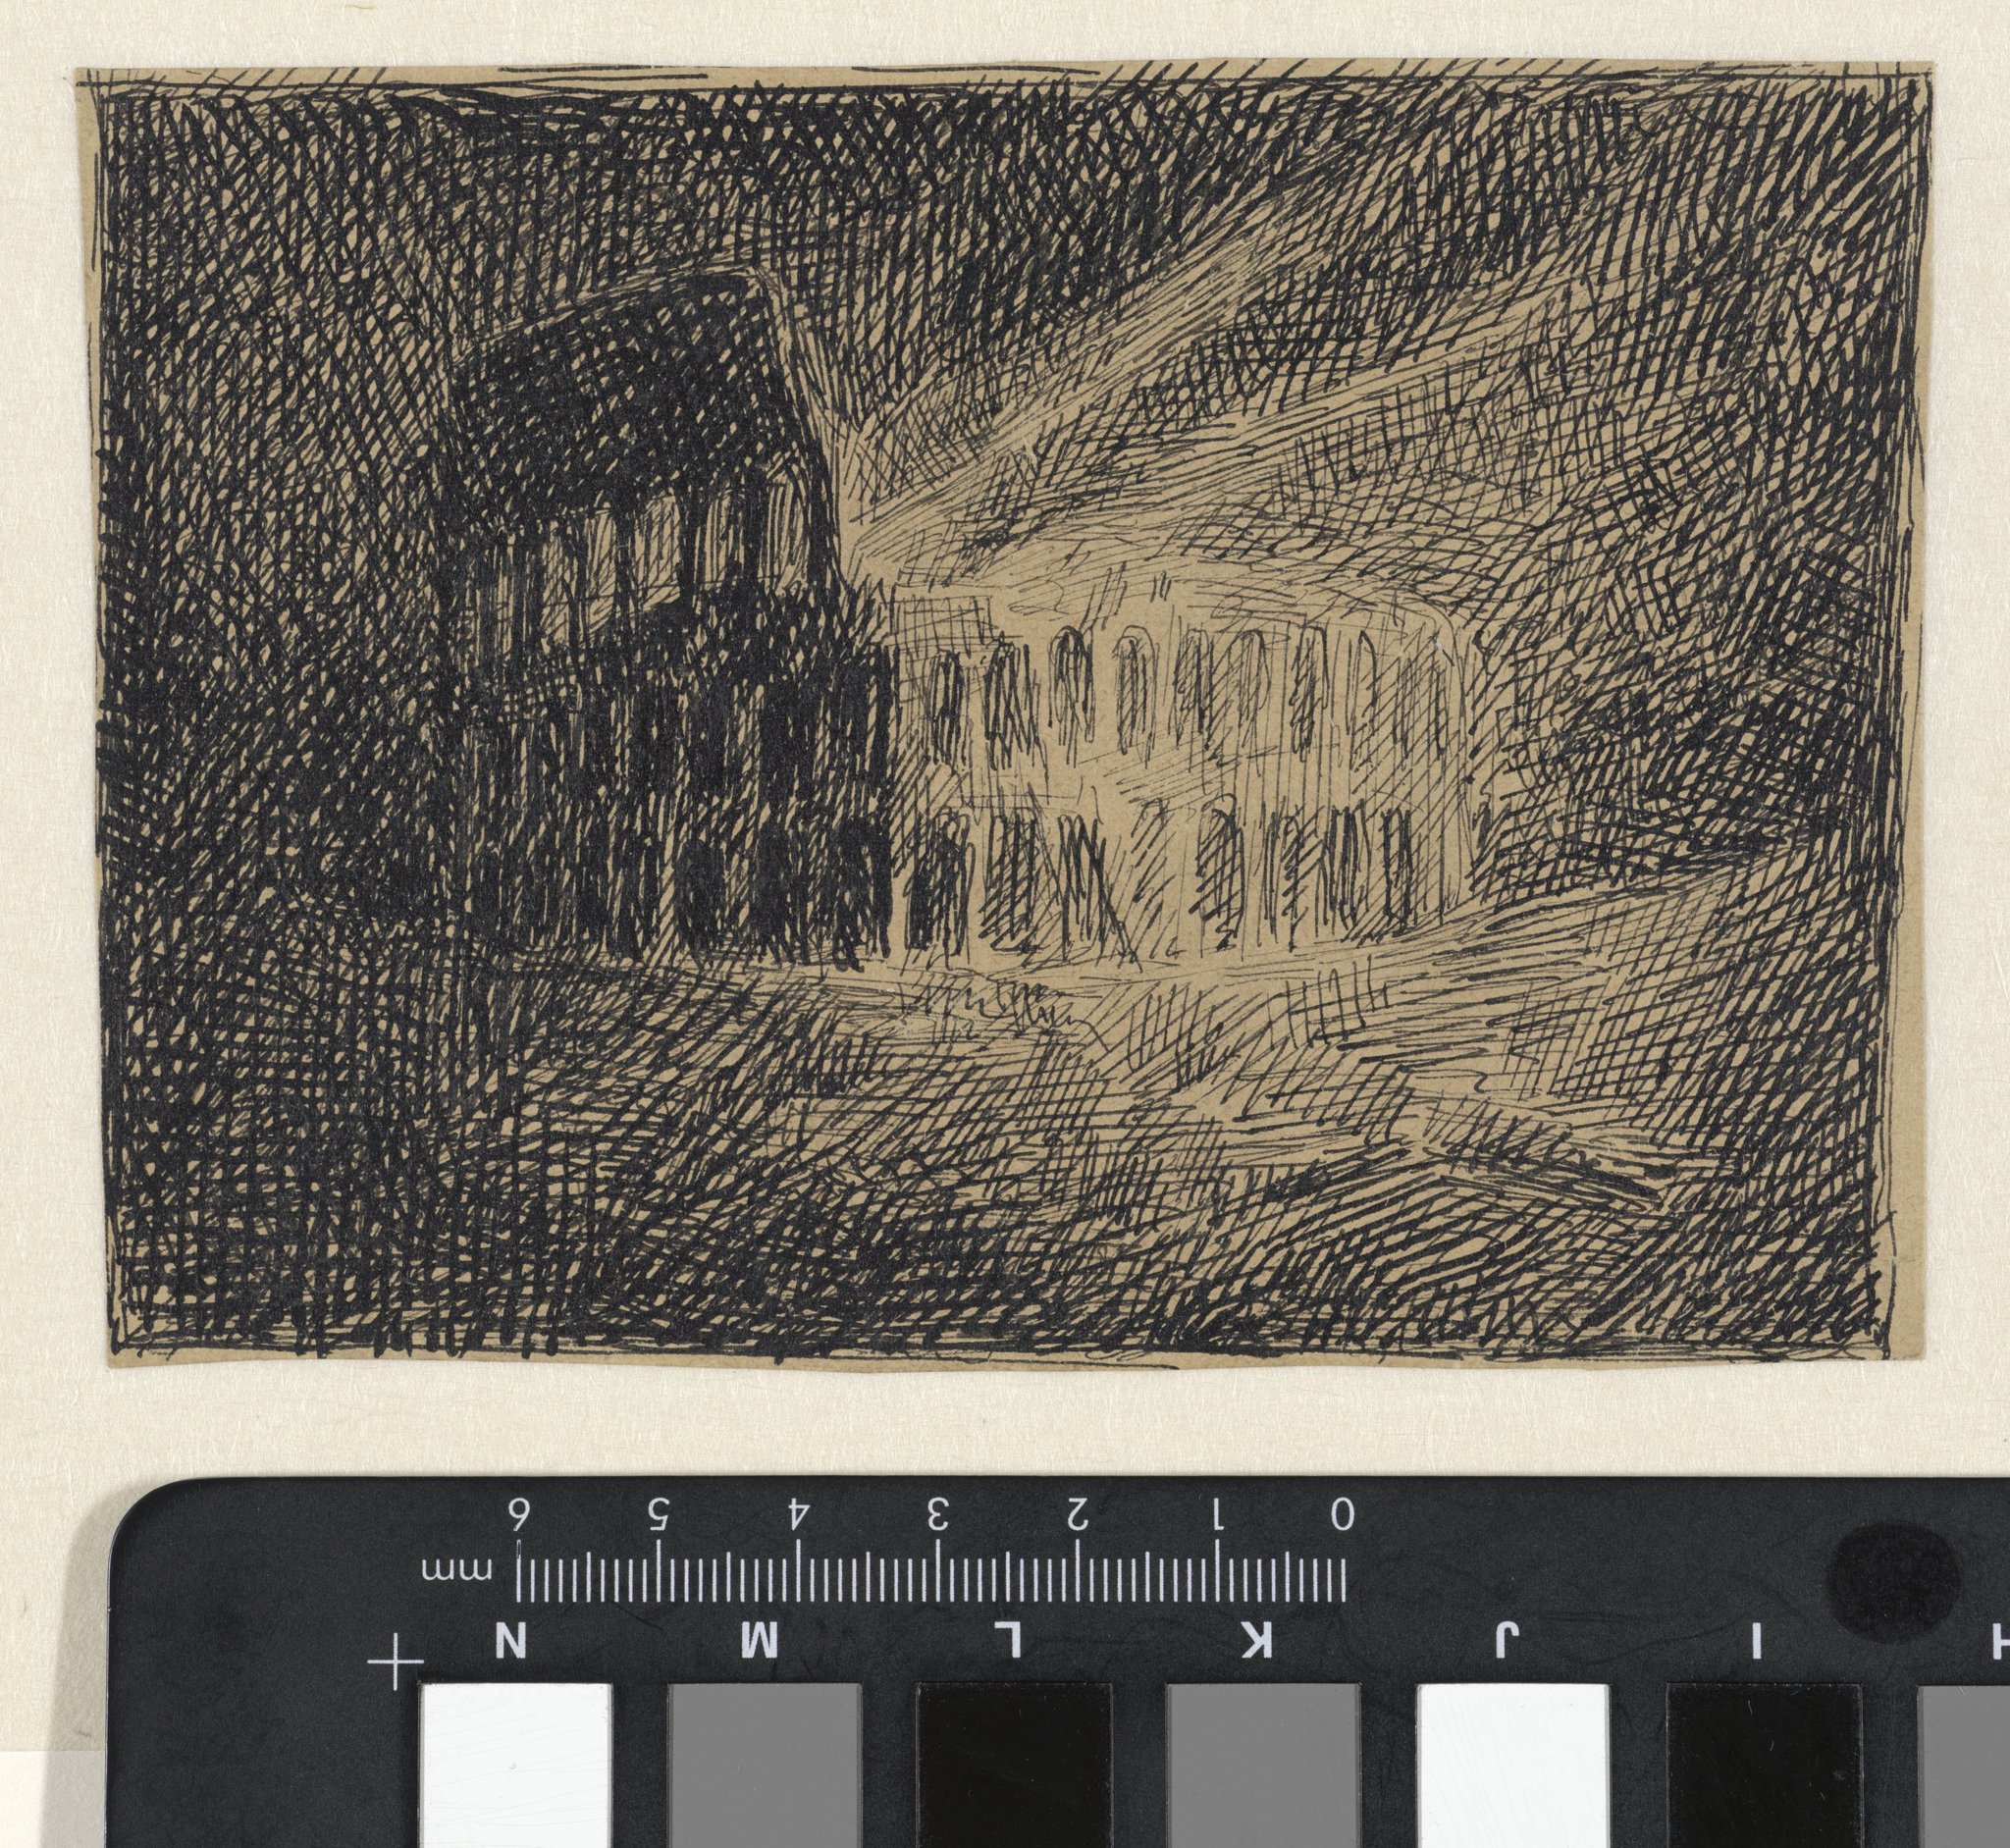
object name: drawing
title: Het Colosseum bij nacht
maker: thomas cool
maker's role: draughtsman, painter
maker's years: 1851-1904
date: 1861-1904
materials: ink, paper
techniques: pen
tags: city-view, and landscape with man-made constructions, amphitheatre, rome